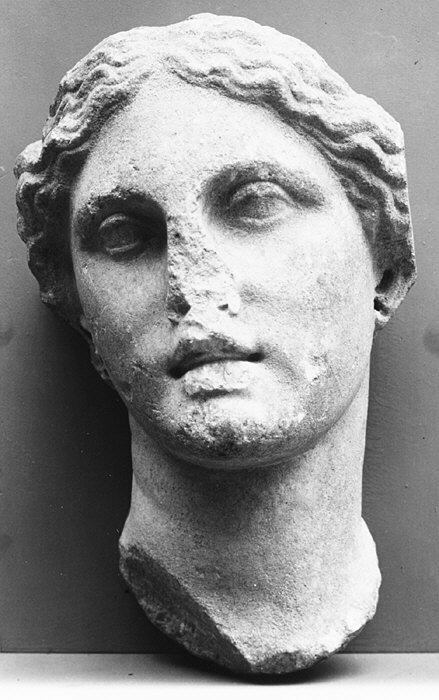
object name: head of a goddess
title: Marble head of a goddess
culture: greek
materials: marble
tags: heads,goddess